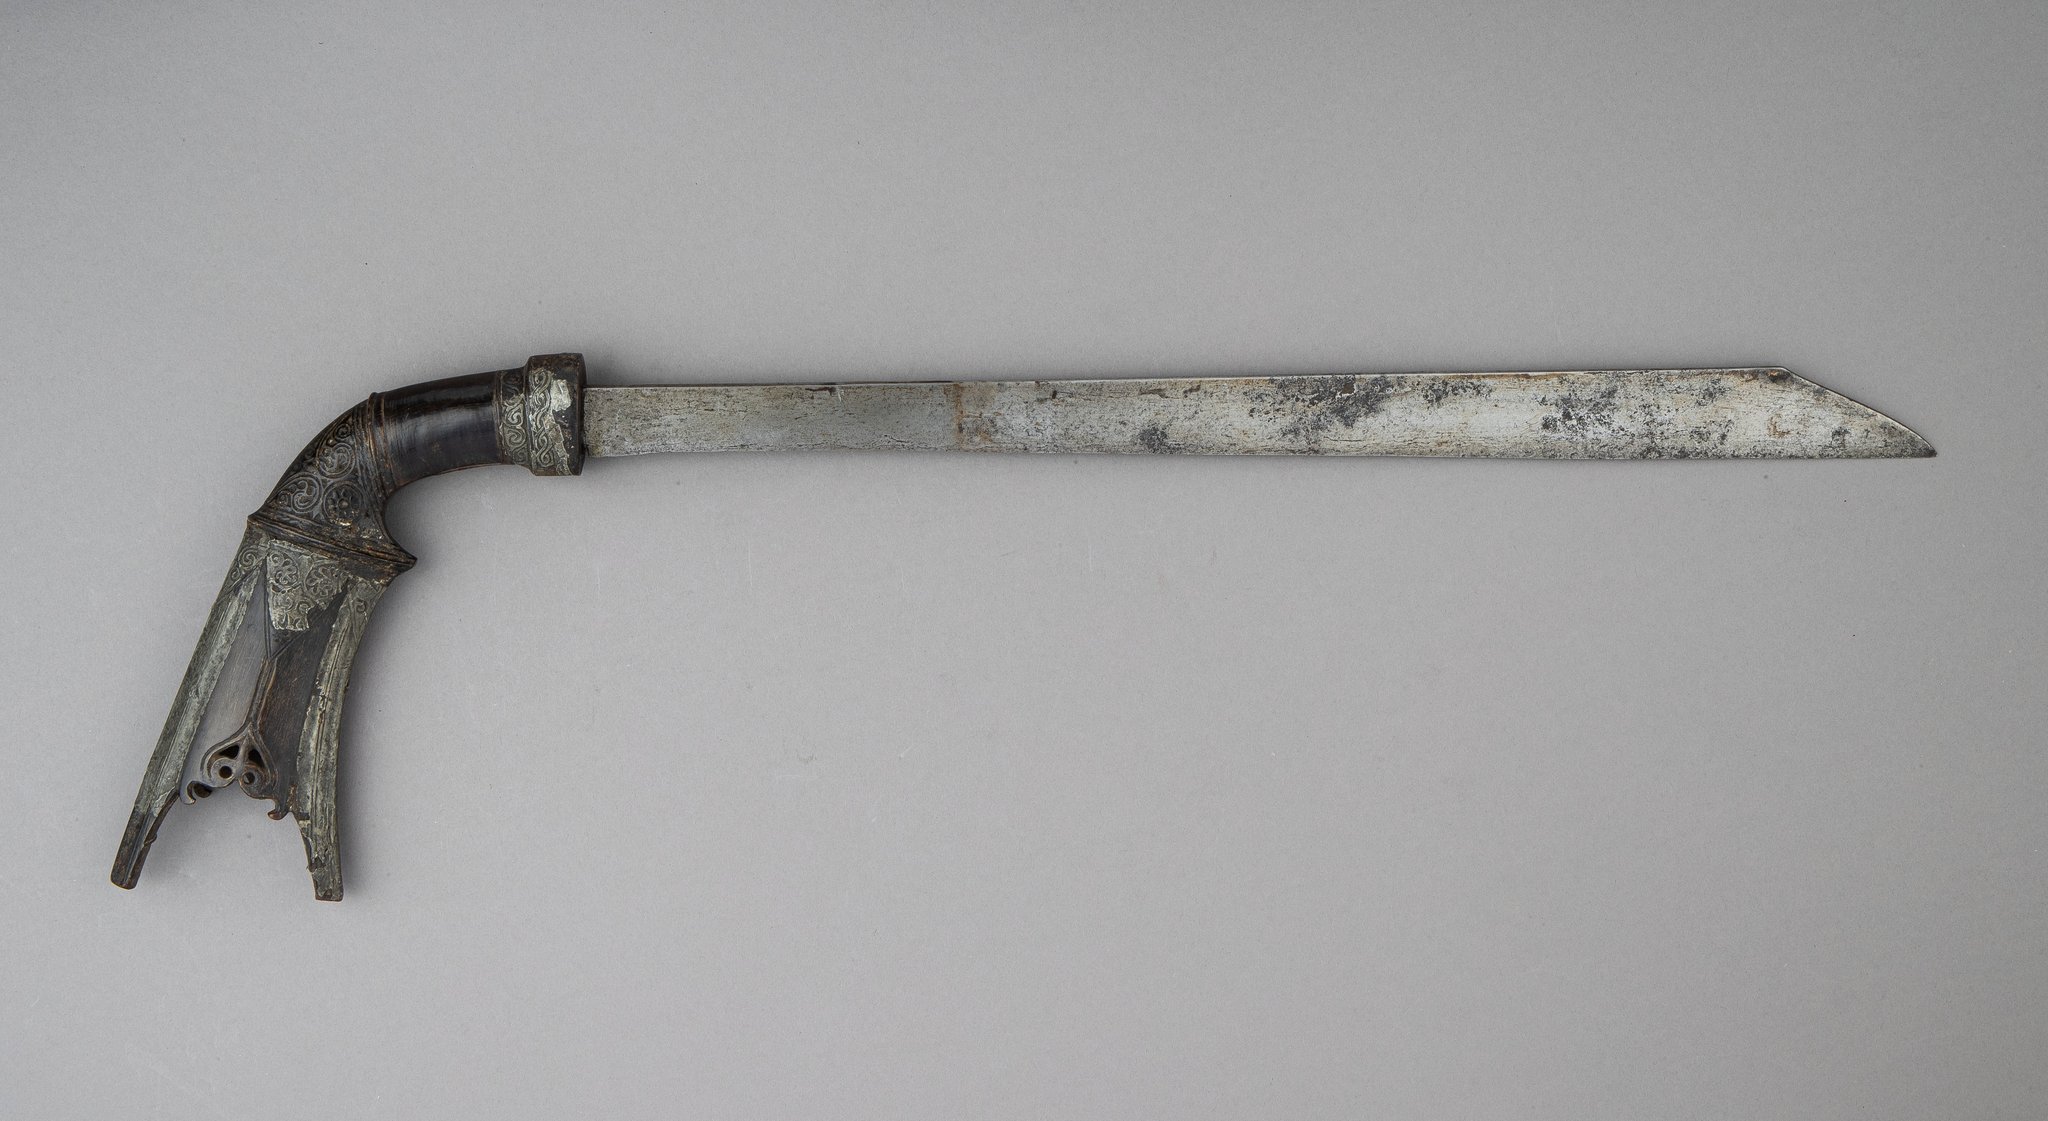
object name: sword klewang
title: Sword (Klewang)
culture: indonesian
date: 1701-1900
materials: foil, horn, tin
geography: indonesia